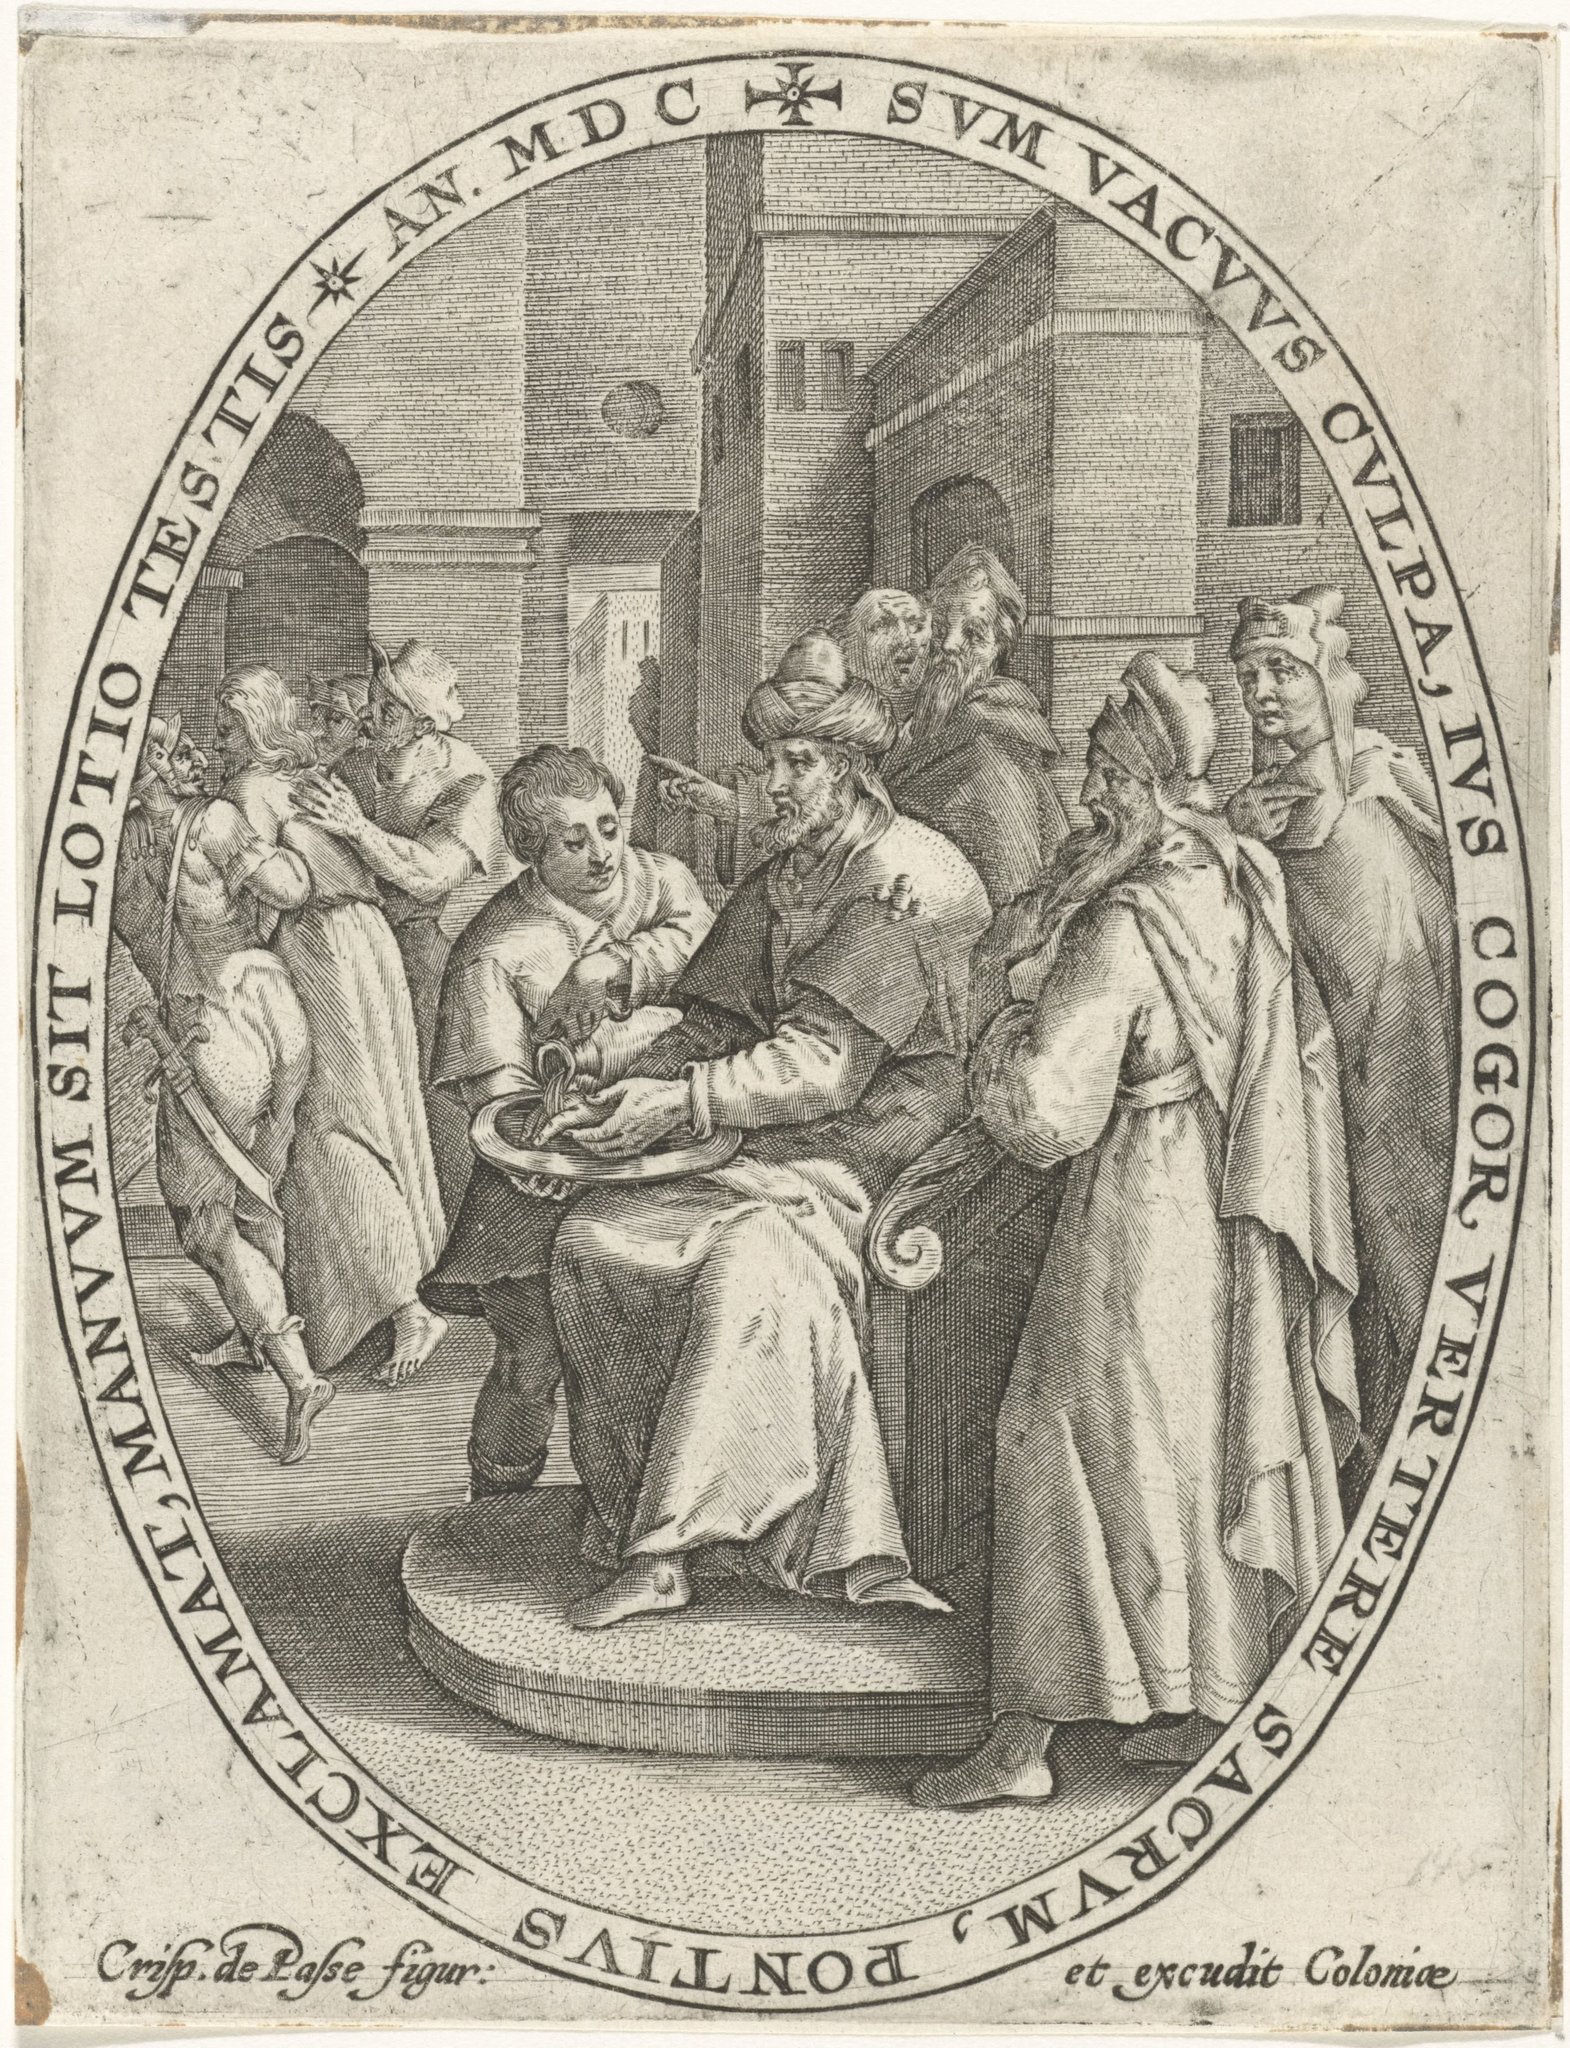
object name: print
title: Passio Domini nostri Jesu Christi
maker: crispijn van de passe (i)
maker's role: draughtsman, print maker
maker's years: 1564-1637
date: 1600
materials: paper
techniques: engraving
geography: cologne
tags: pilate washing his hands (in innocence)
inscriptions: collector's mark: Lugt 2542, collector's mark: Lugt 2228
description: Christus wordt ter dood veroordeeld en afgevoerd. Pilatus wast zijn handen in onschuld. De voorstelling is gevat in een ovale omlijsting met een randschrift in het Latijn. Prent uit een serie met de passie van Christus.